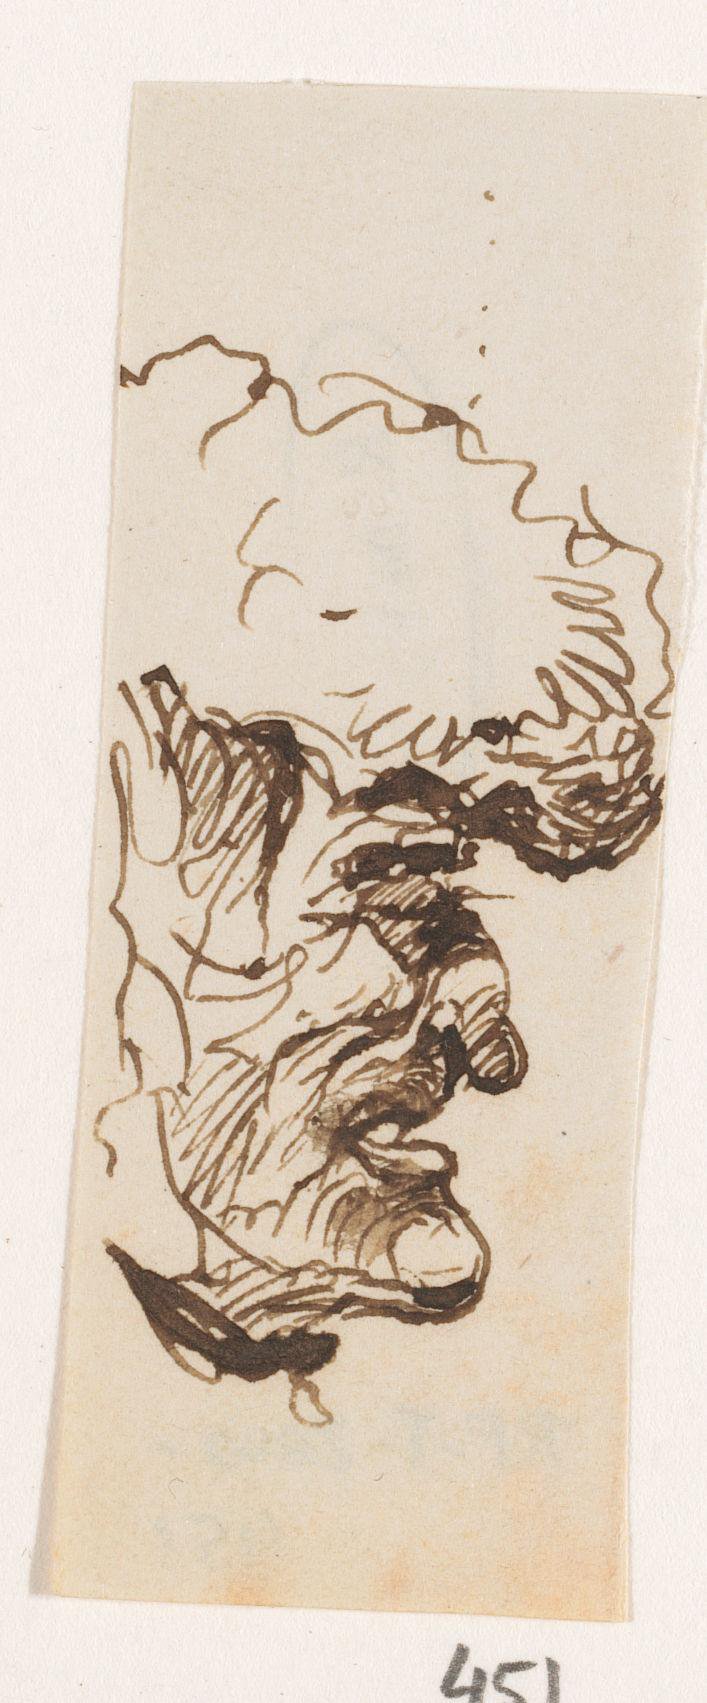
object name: drawing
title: Kop met bontmuts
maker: johannes tavenraat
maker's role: draughtsman, painter, print maker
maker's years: 1809-1881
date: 1840-1880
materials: ink, paper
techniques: pen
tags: caricatures (human types)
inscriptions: collector's mark: Lugt 2228